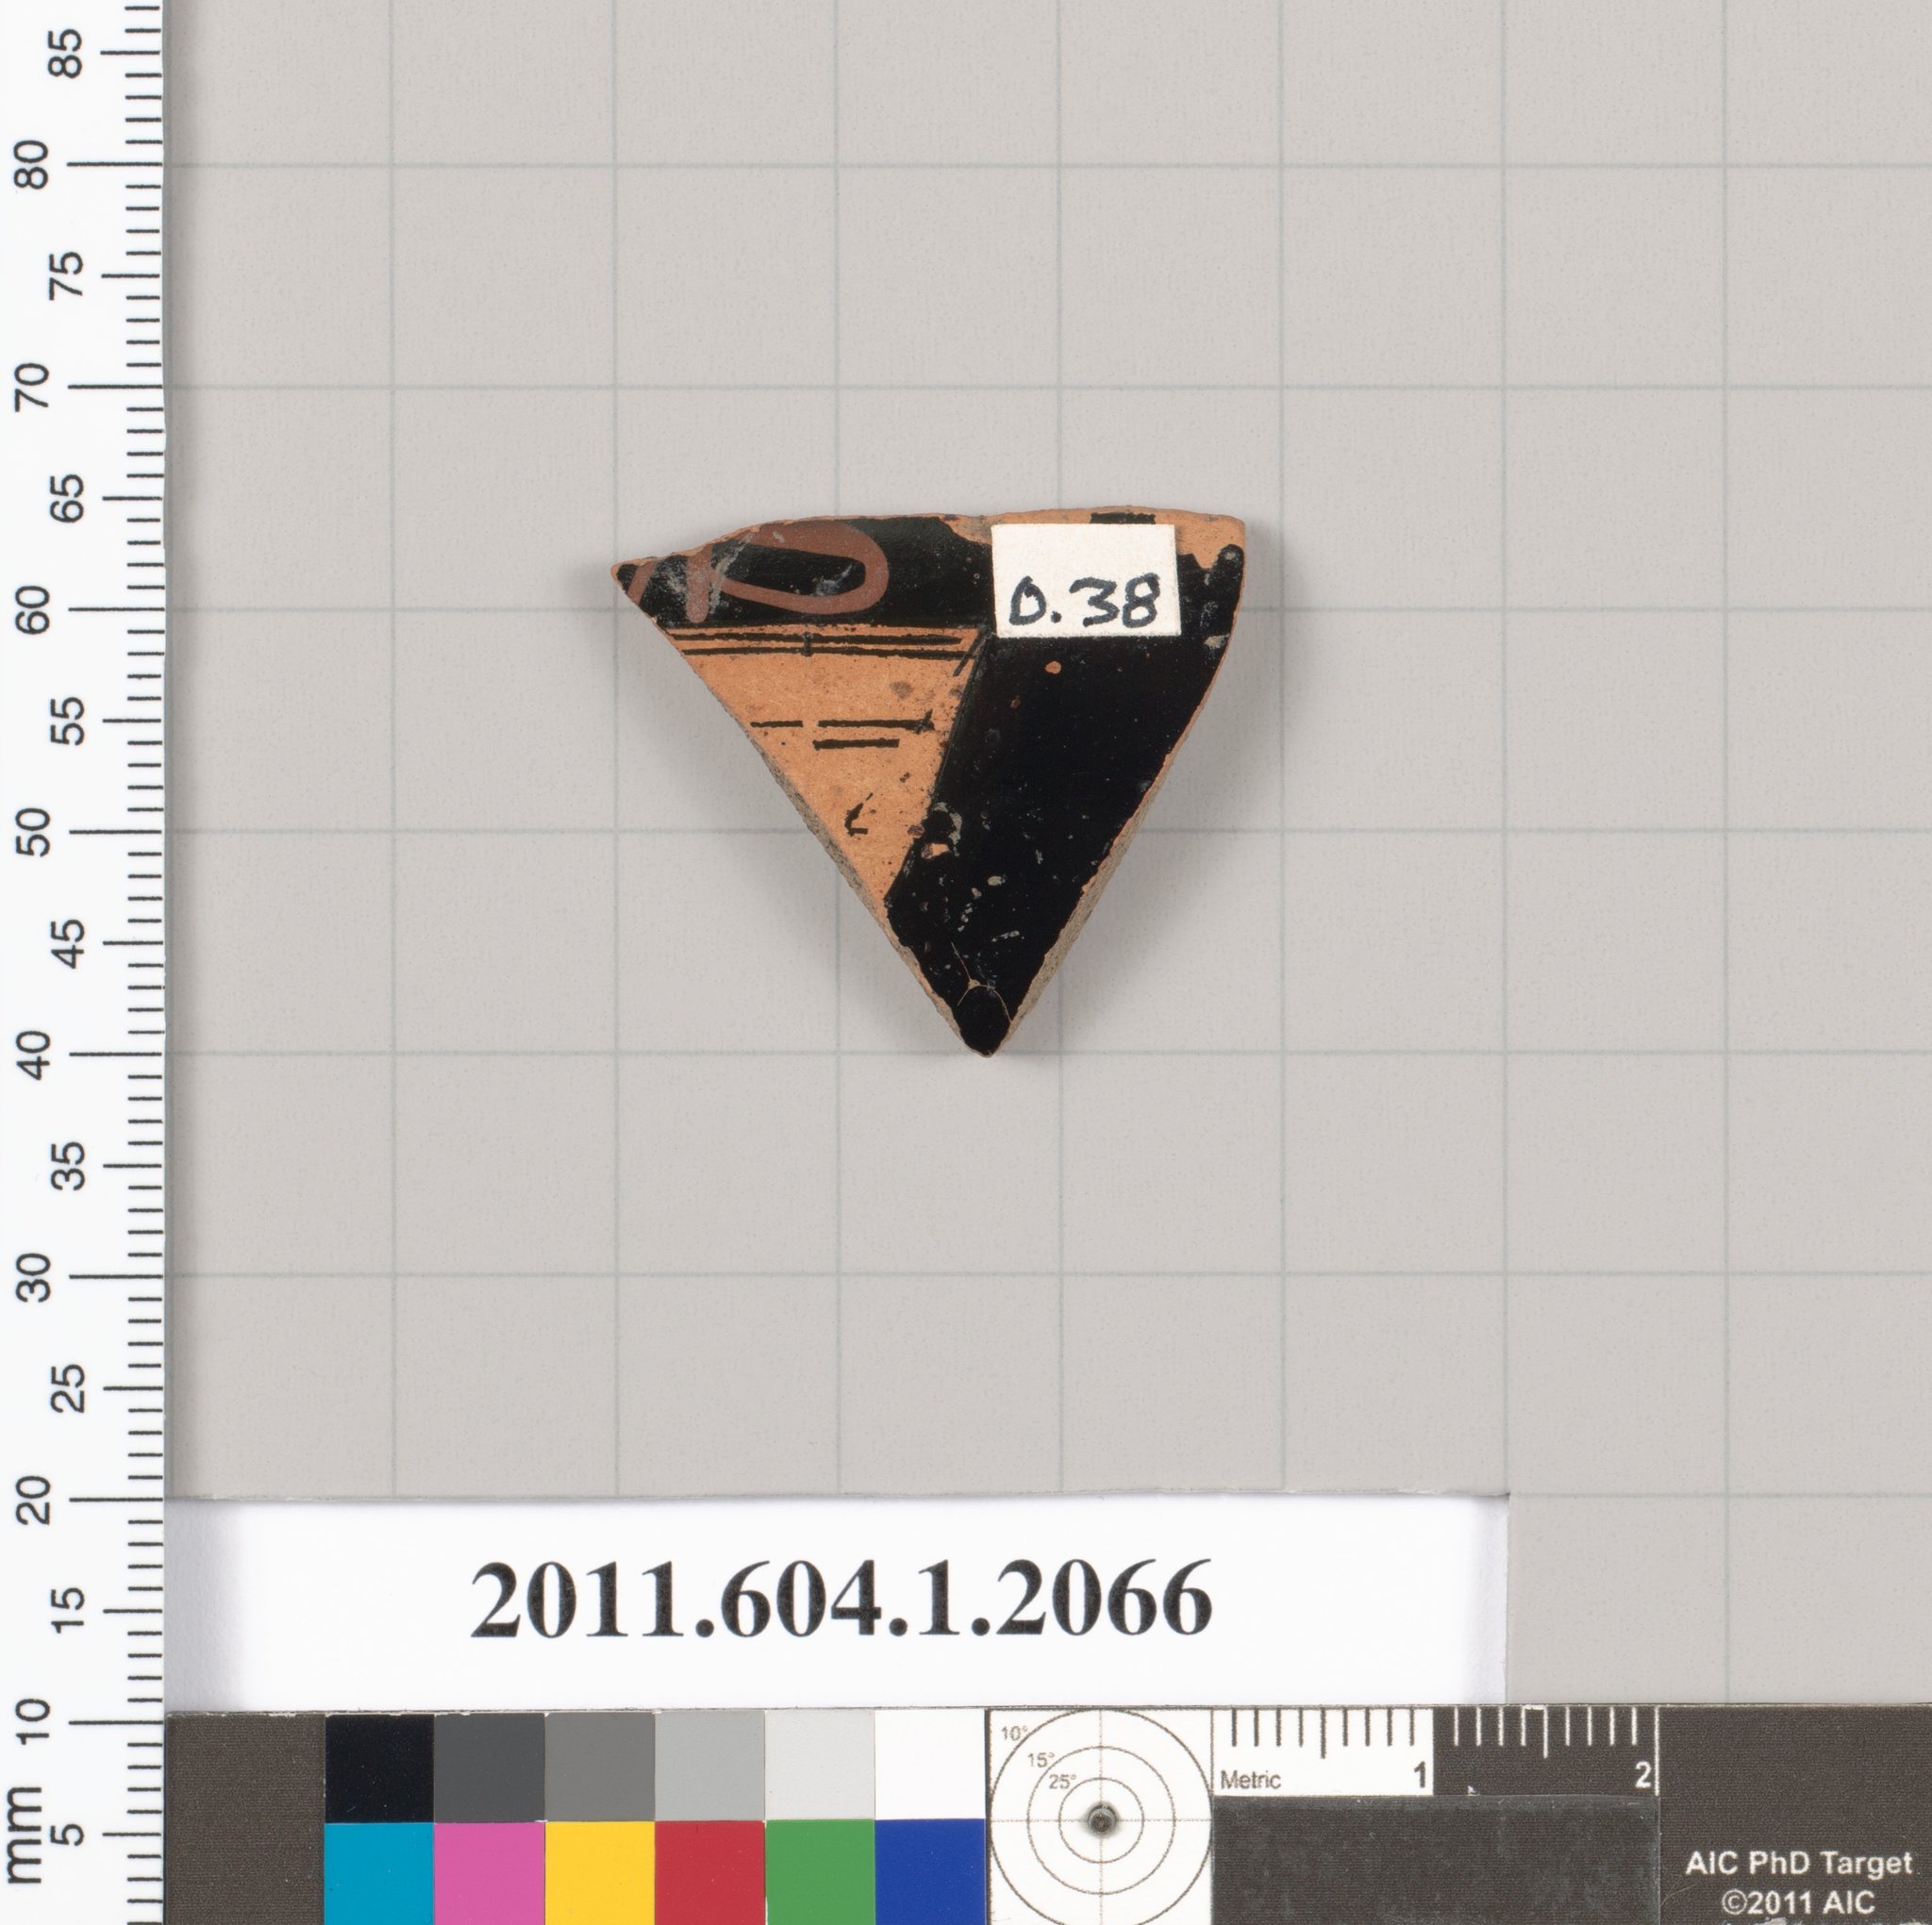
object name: kylix fragment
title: Terracotta rim fragment of a kylix (drinking cup)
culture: greek, attic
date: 490-480 BCE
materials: terracotta